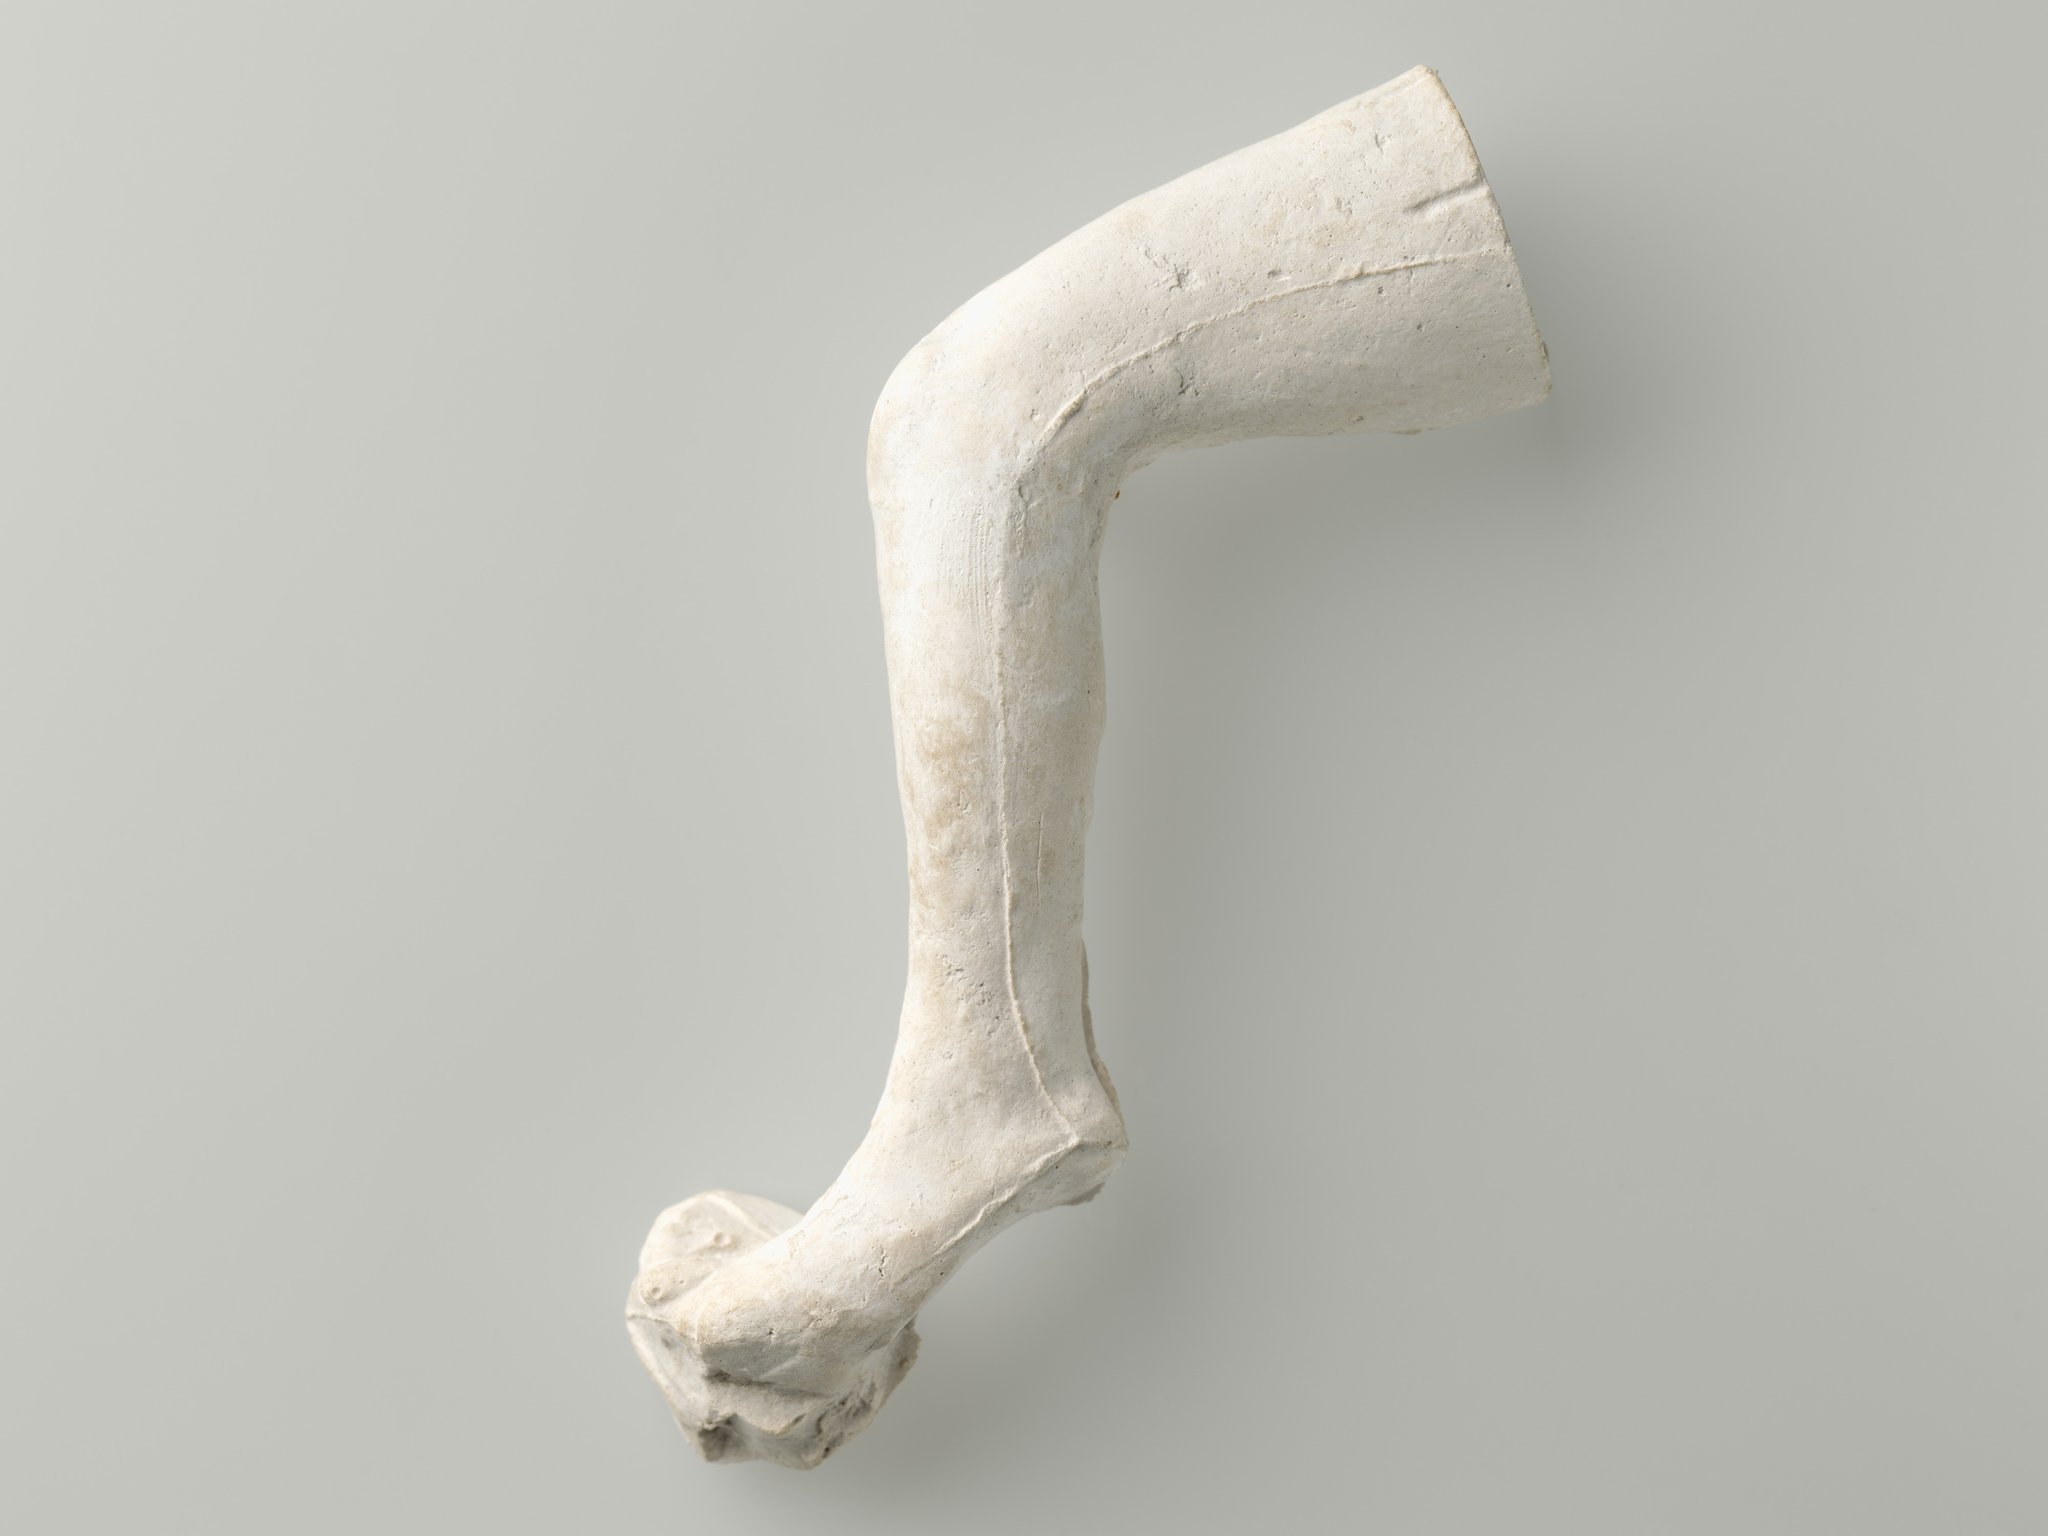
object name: cast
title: Study of a leg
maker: auguste rodin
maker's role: artist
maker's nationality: french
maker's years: 1840-1917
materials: plaster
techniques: casting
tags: legs